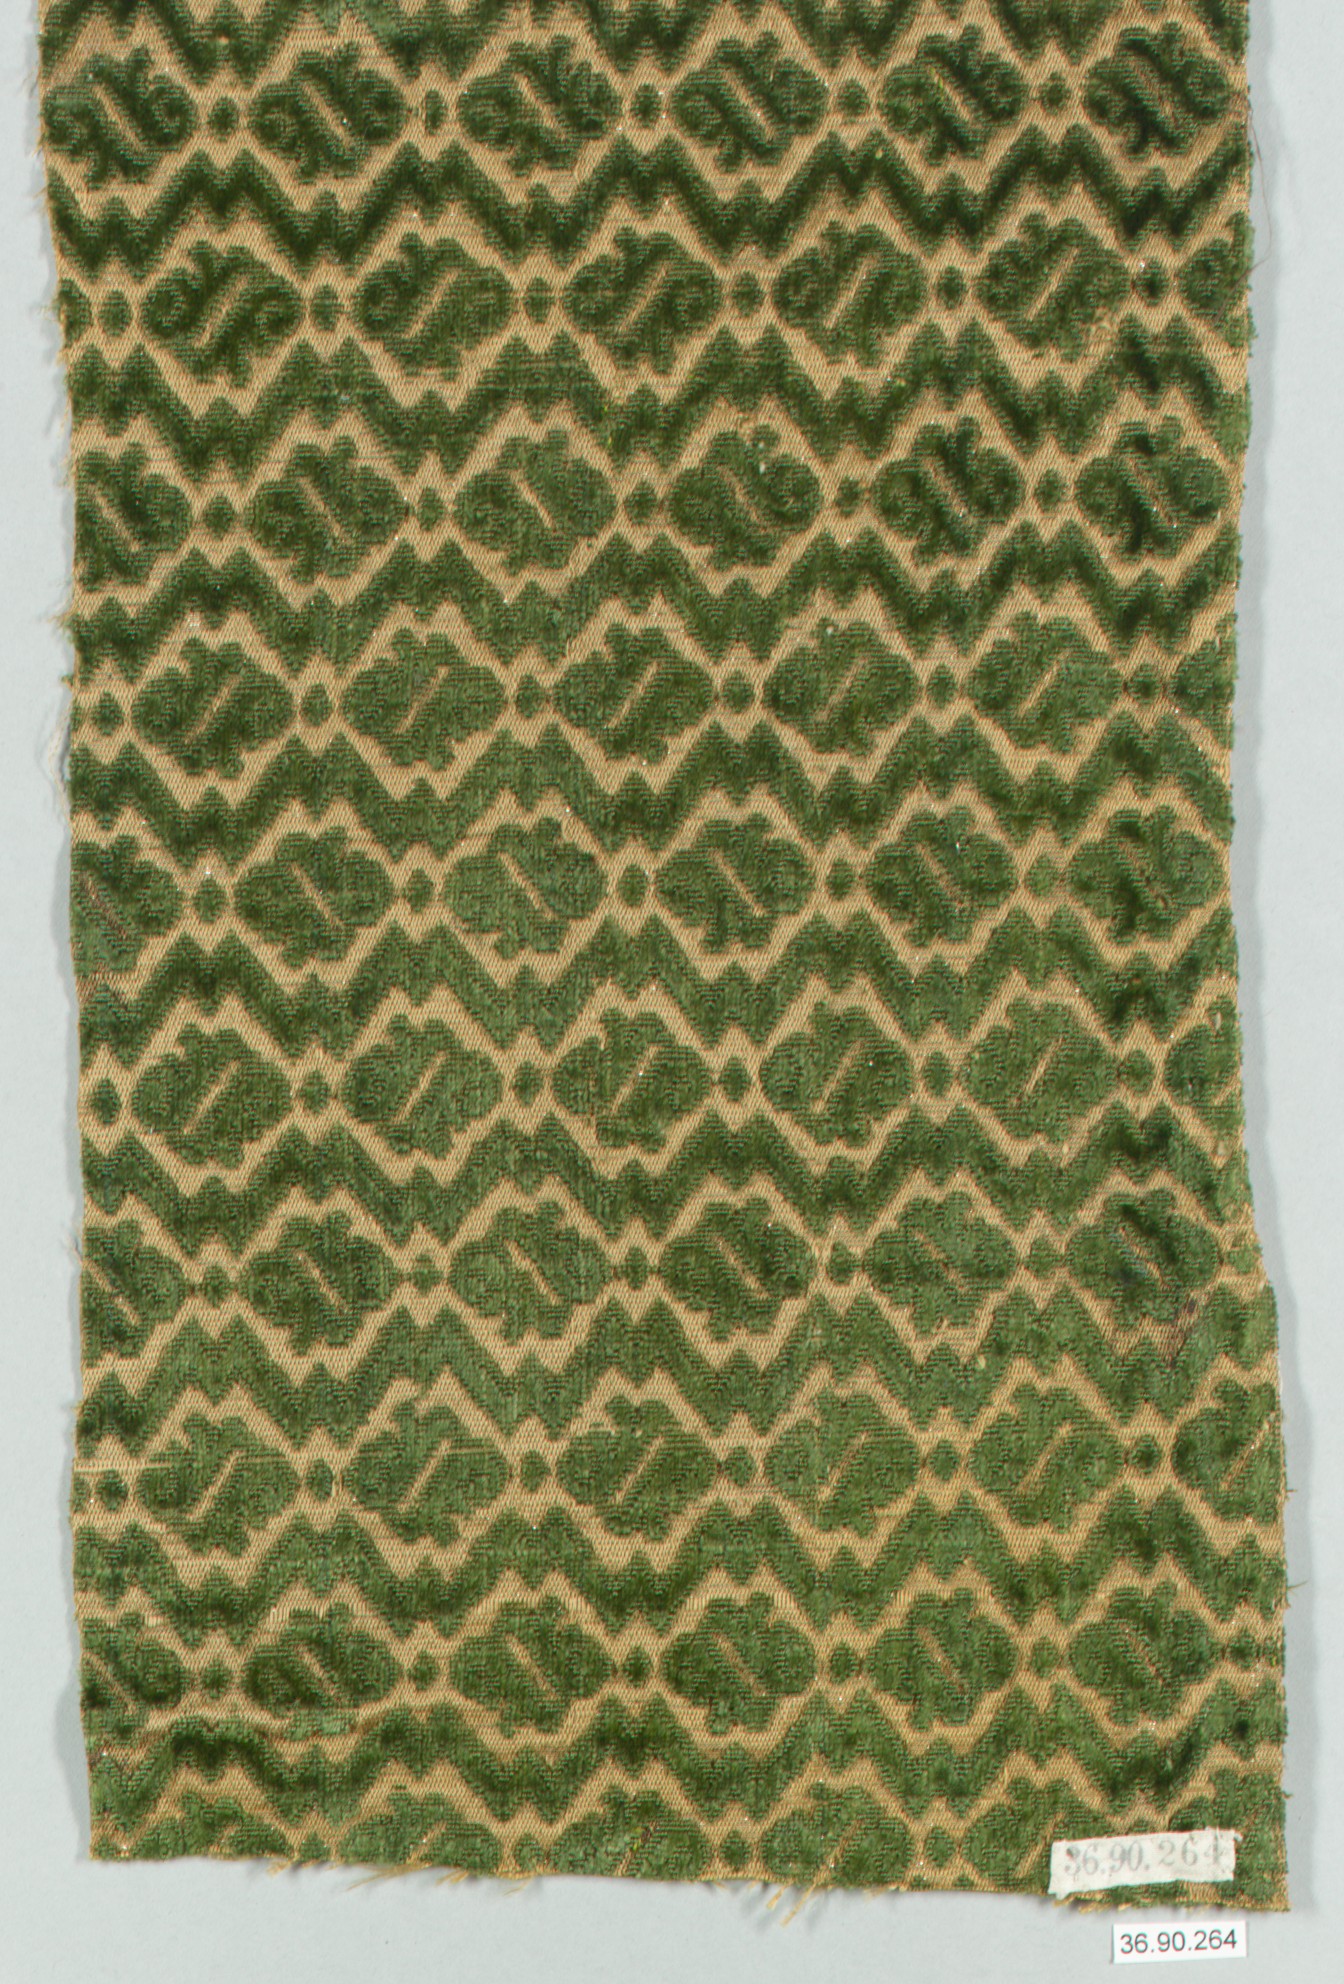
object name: piece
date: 1501-1700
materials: metal thread, silk